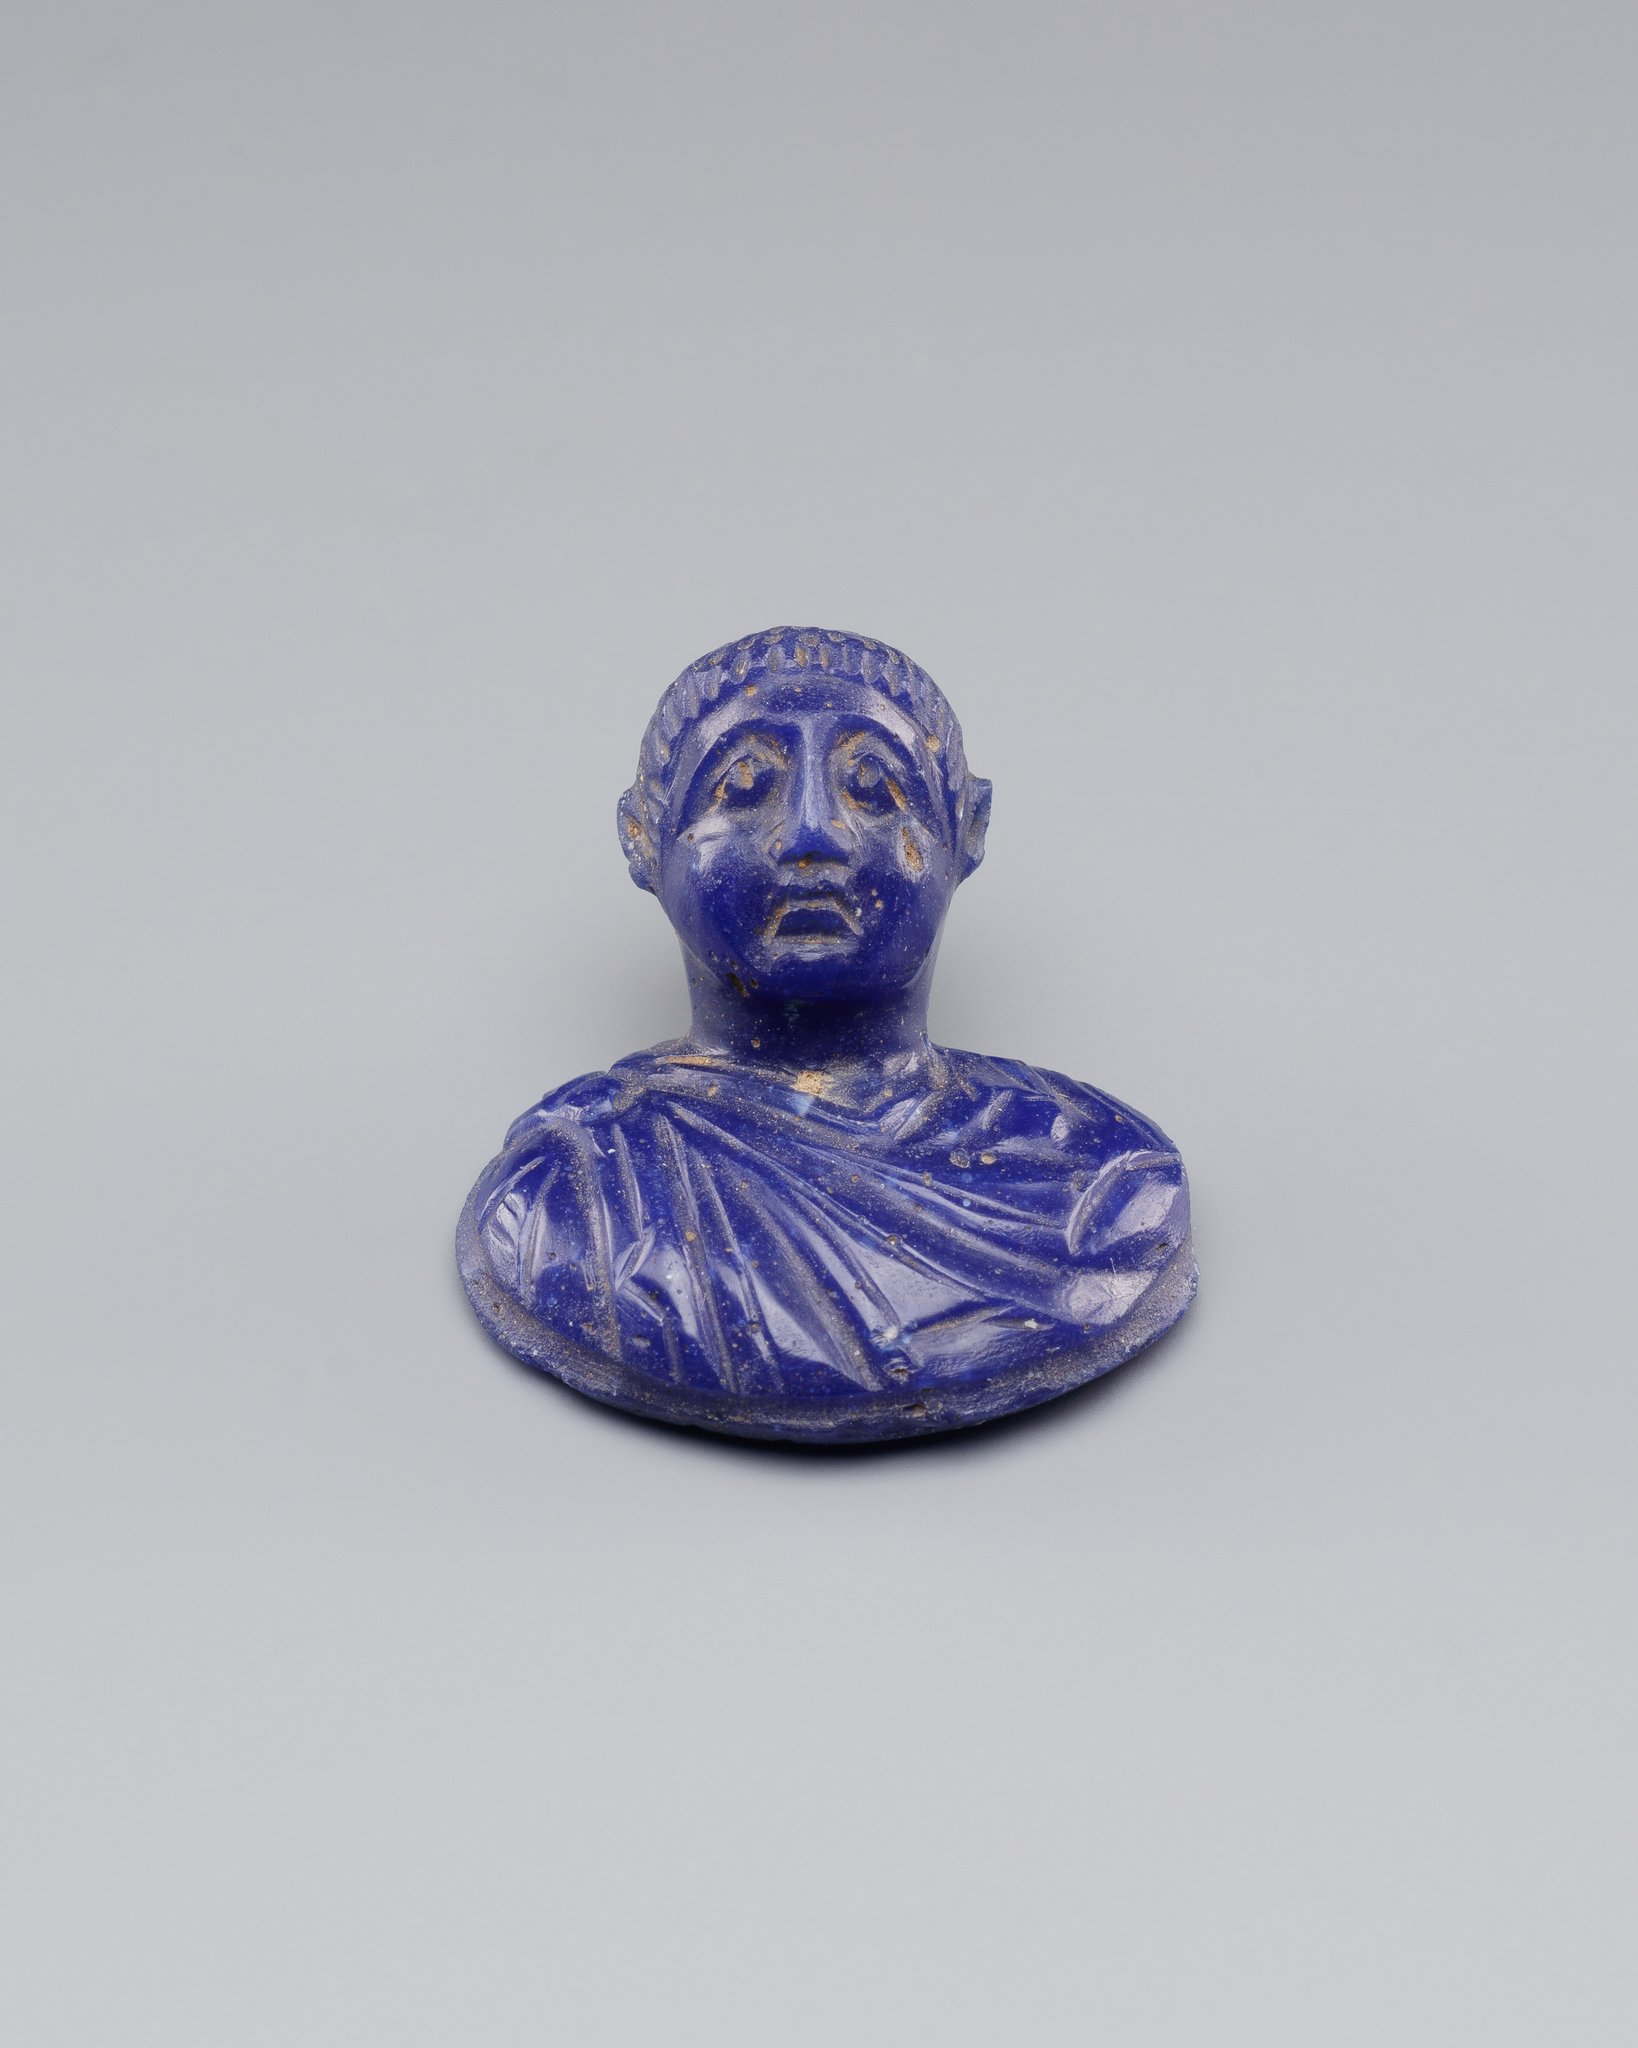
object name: bust, constantinian family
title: Miniature Bust of a Member of the Constantian Dynasty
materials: glass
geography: egypt or italy